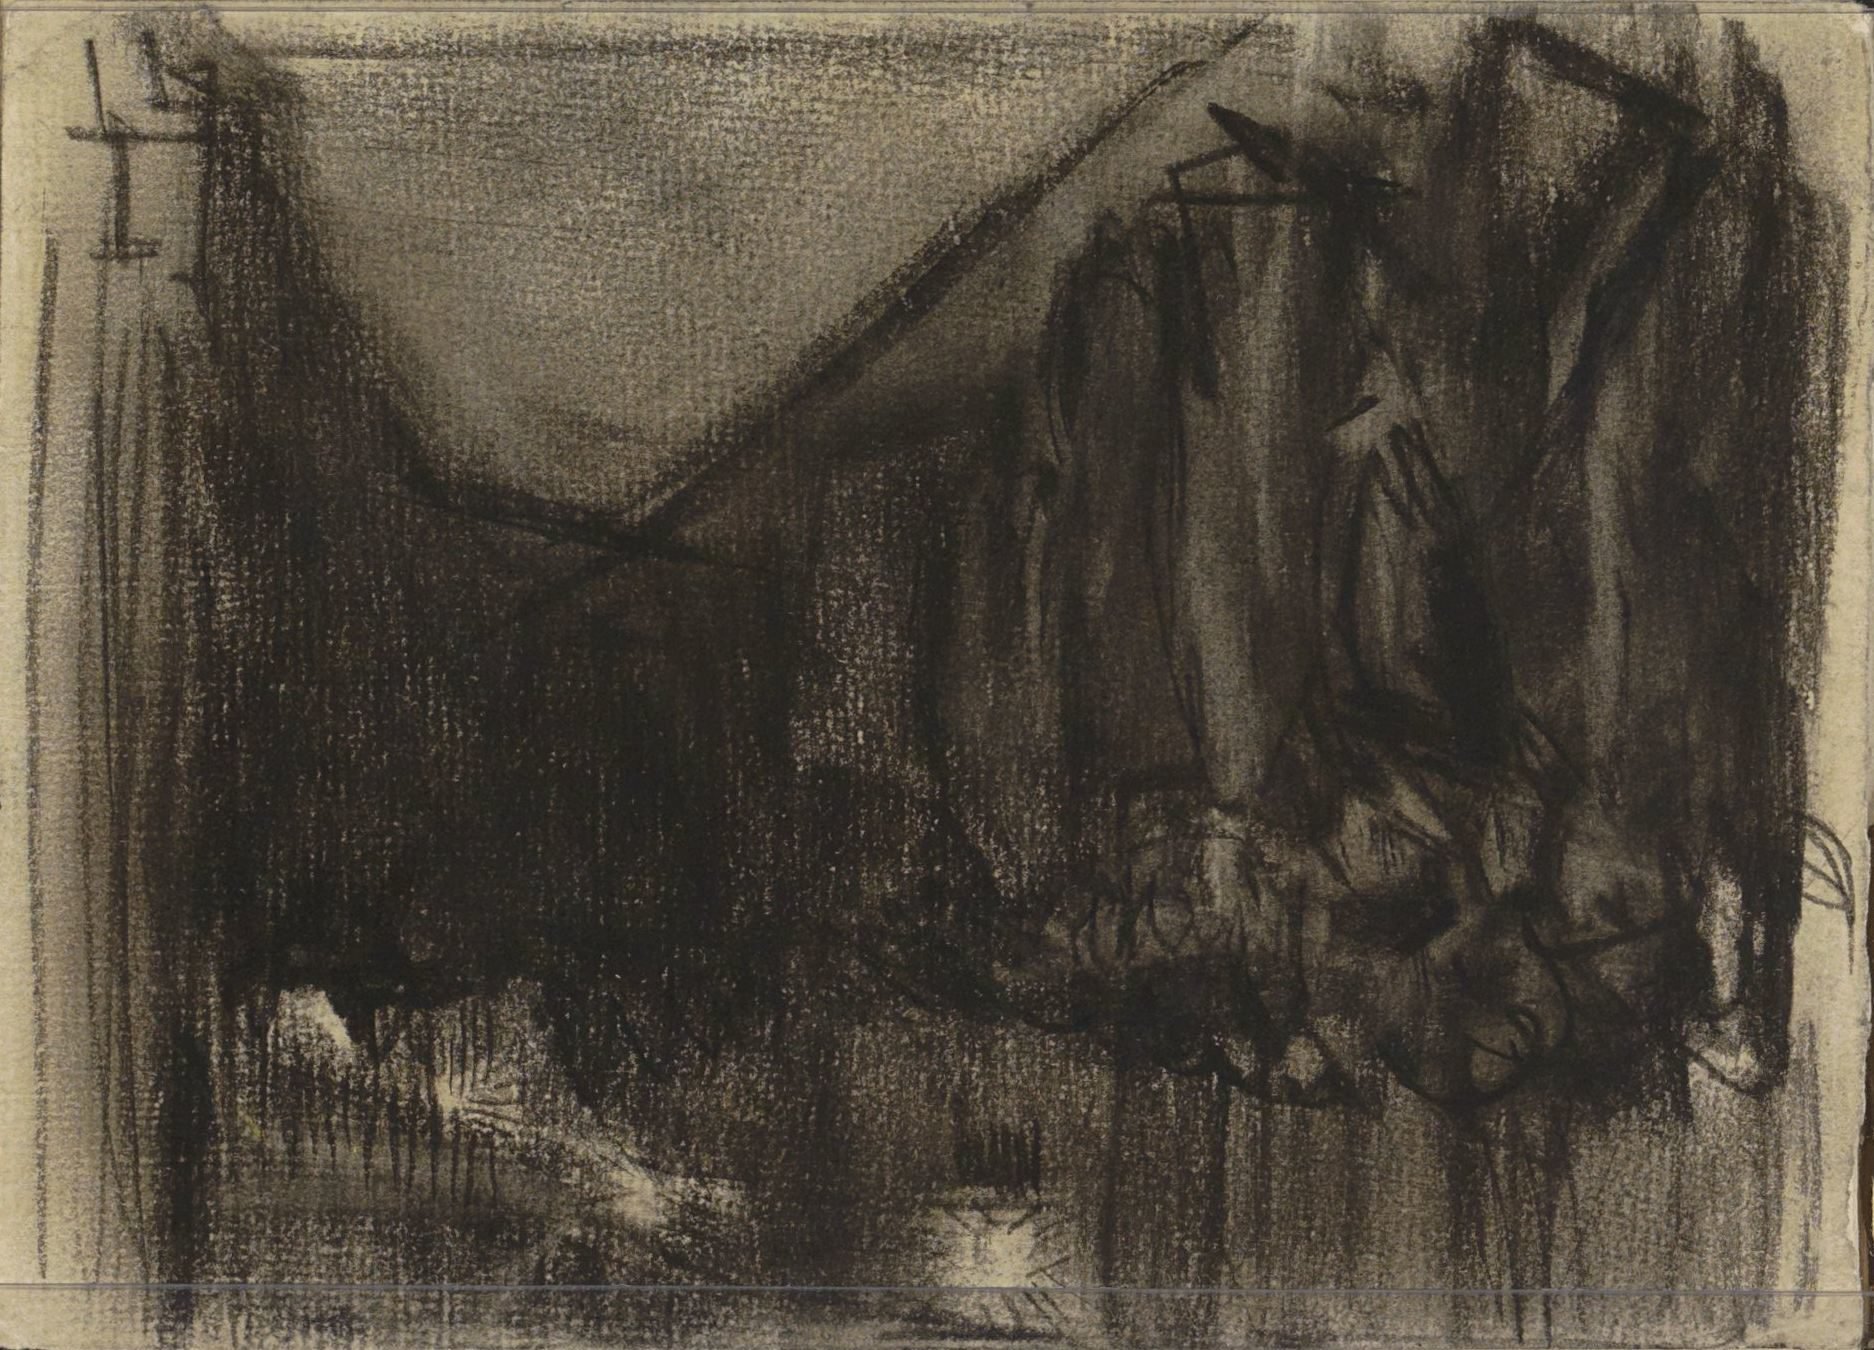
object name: drawing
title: Figuren, mogelijk op straat bij avond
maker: isaac israels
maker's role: draughtsman, painter, print maker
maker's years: 1865-1934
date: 1886-1903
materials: chalk, paper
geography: amsterdam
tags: street (+ city(-scape) with figures, staffage), amsterdam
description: Losse tekening, blad 1 verso, aangetroffen tussen pagina 50 en het achterste schutblad in schetsboek XLVII met 52 pagina's.